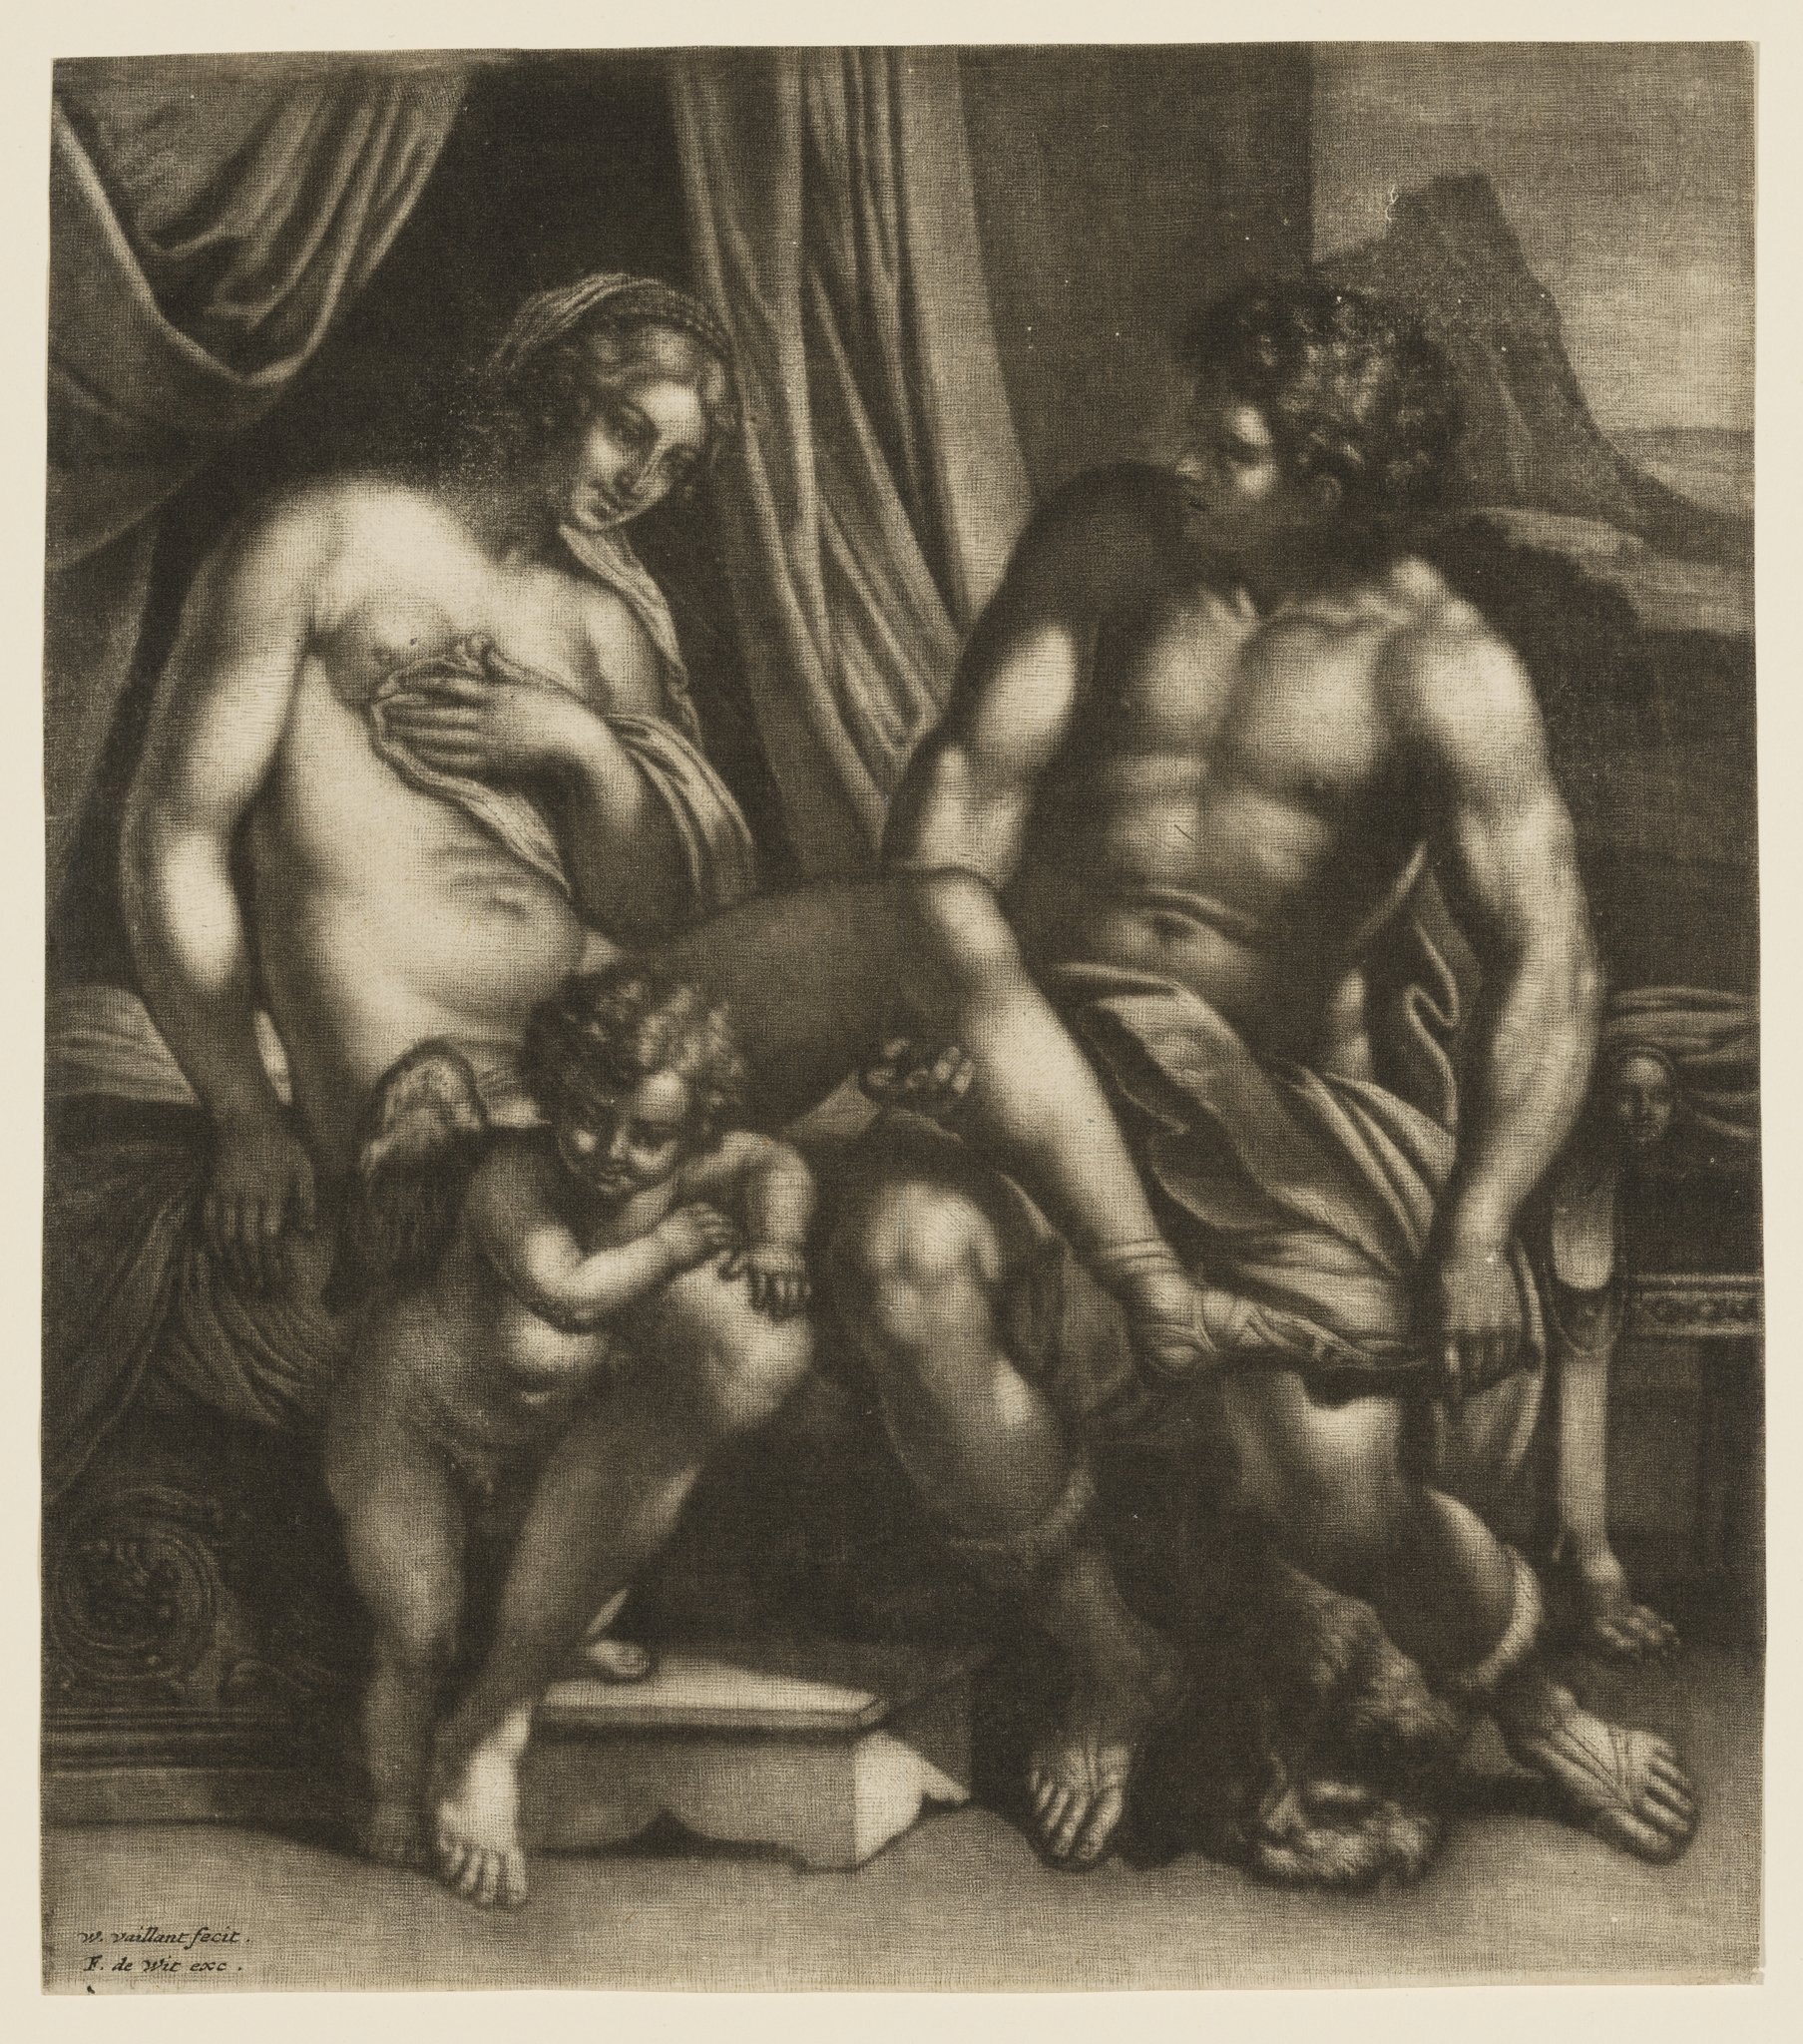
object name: print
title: Venus and Anchises, accompanied by Cupid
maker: wallerant vaillant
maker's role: artist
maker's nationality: dutch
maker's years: 1623-1677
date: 1601-1700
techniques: mezzotint